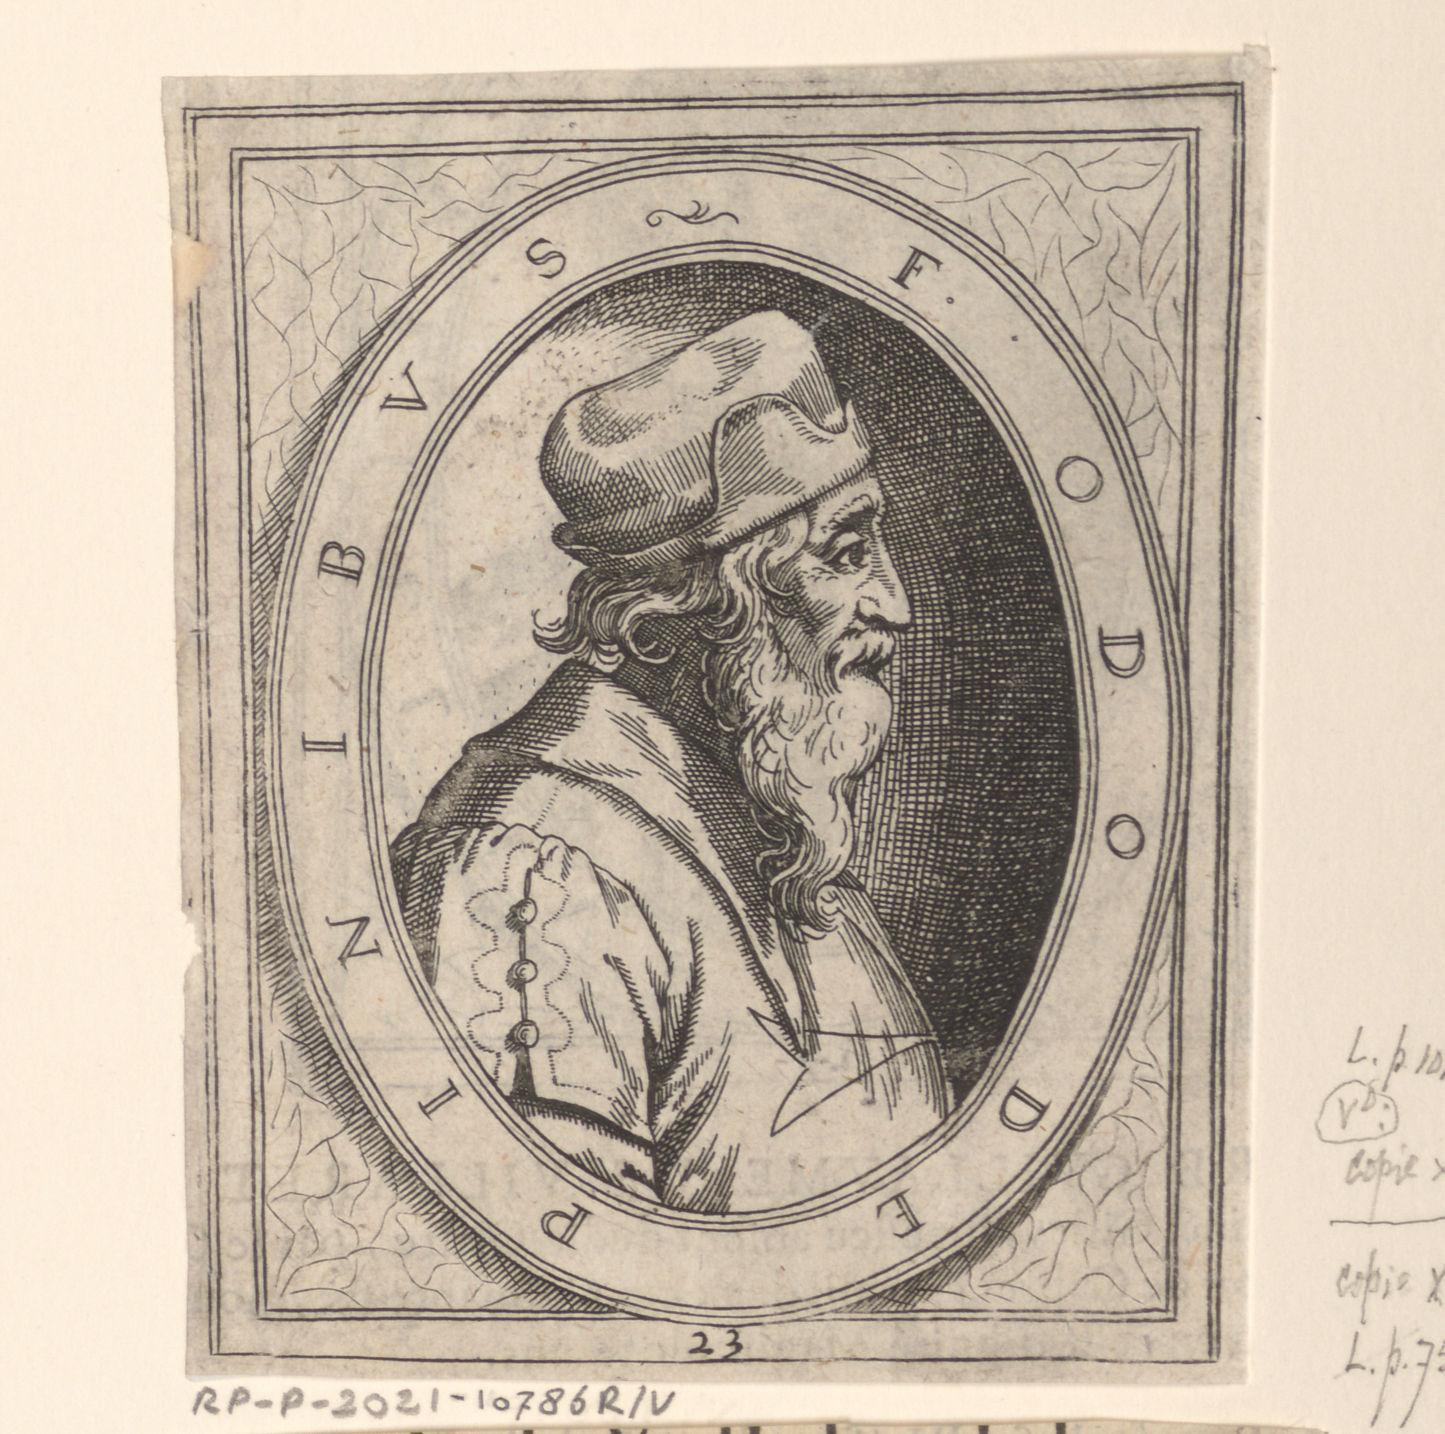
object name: print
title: Portret van Odon de Pins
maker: Anonymous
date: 1643-1659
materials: paper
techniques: engraving, etching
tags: historical persons, military orders, e.g.: knights templars, knights of malta, teutonic knights ~ roman catholic church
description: Prent mogelijk uit: Baudoin, Jean. Histoire des chevaliers de l'ordre de s. Jean de Hierusalem (...). Parijs: Jacques Dallin, 1643. Of uit: Baudoin, Jean. Histoire des chevaliers de l'ordre de s. Jean de Hierusalem (...). Parijs: Thomas Jolly, 1659.